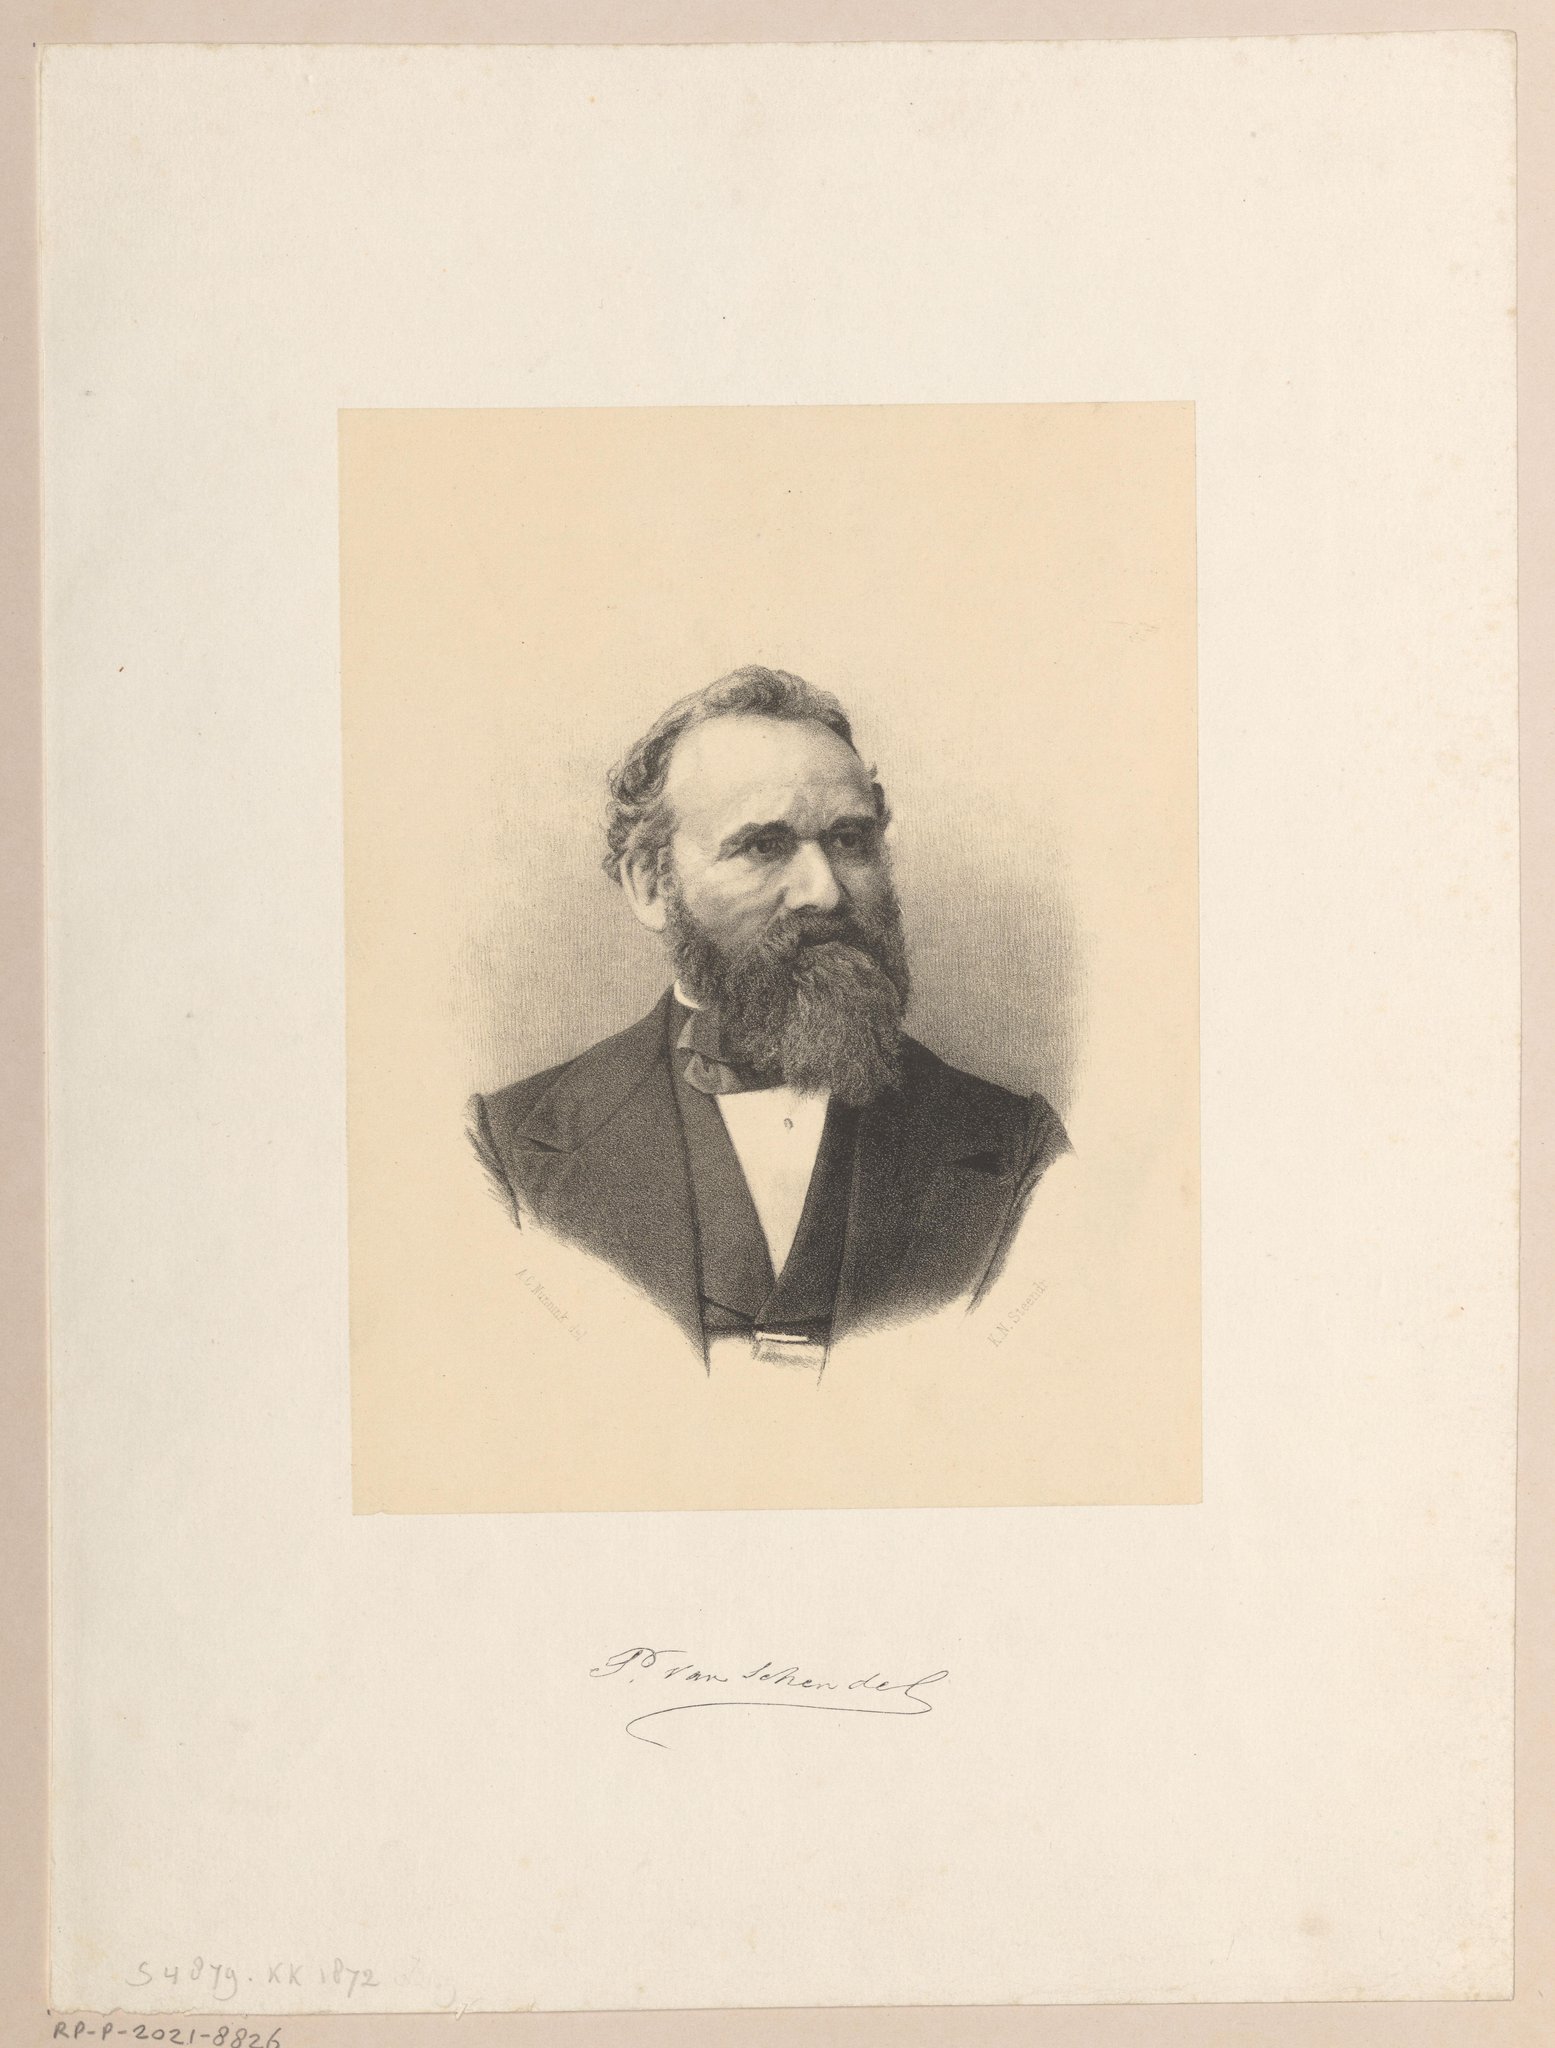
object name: print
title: Portret van Petrus van Schendel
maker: adolf carel nunnink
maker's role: print maker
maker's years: 1813-1894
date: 1872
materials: paper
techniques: lithograph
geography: the hague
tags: brussels, painter, print maker, draughtsman, petrus van schendel, historical persons, portrait, self-portrait of painter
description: Prent waarschijnlijk uit: Kunstkronijk (...) 13 (1872).